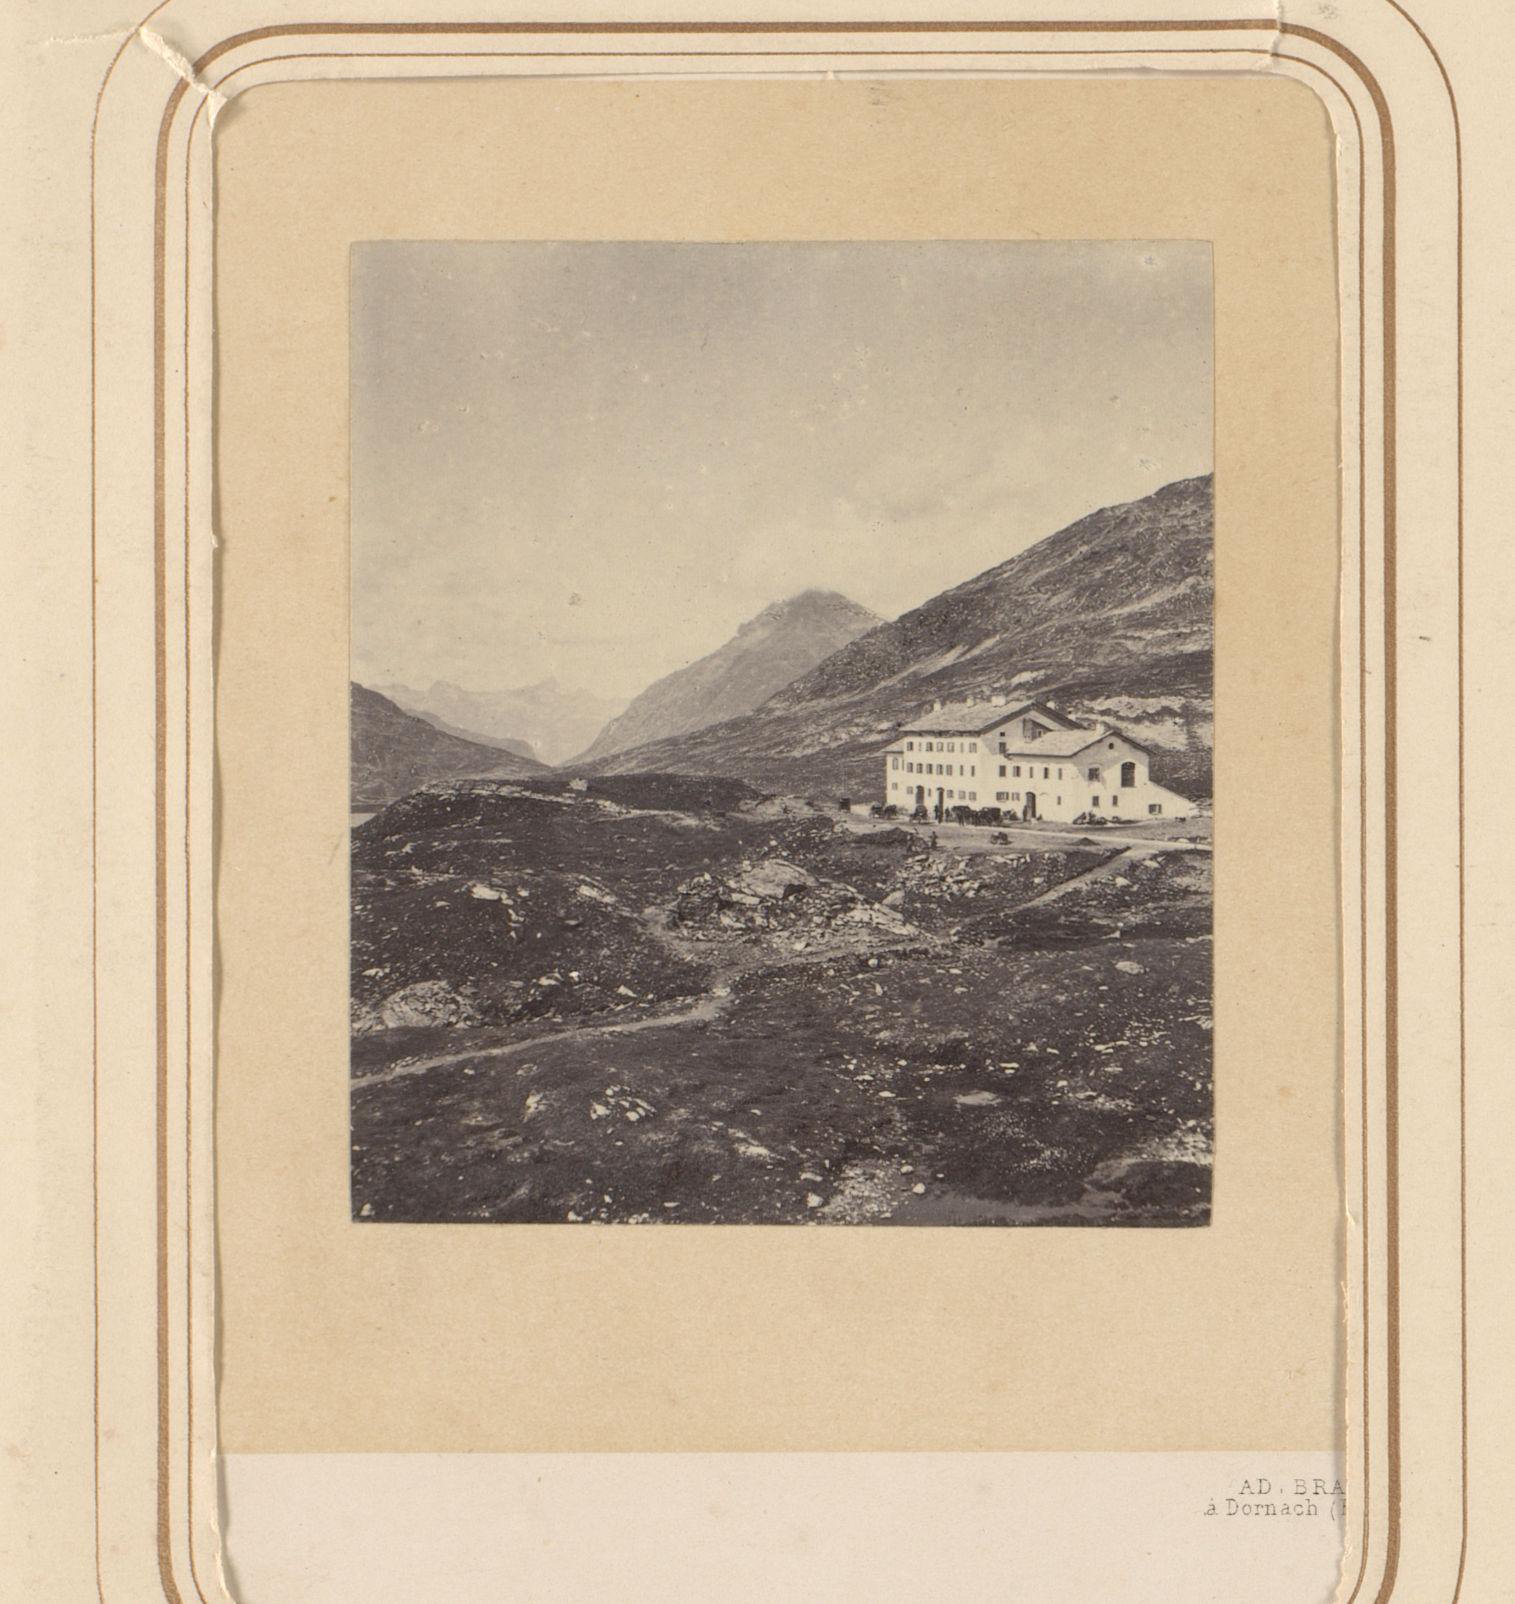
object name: cabinet photograph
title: Huis in een bergachtig landschap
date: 1865-1890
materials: cardboard, photographic support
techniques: albumen print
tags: civic architecture; edifices; dwellings, mountains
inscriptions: inscription: ‘Ad. Braun/ á Dornach (Ht. Rhin)’, inscription: ‘No 5645. Hospice de la Bernina, Le Piz Ote./ (Haute-Engadine.)’